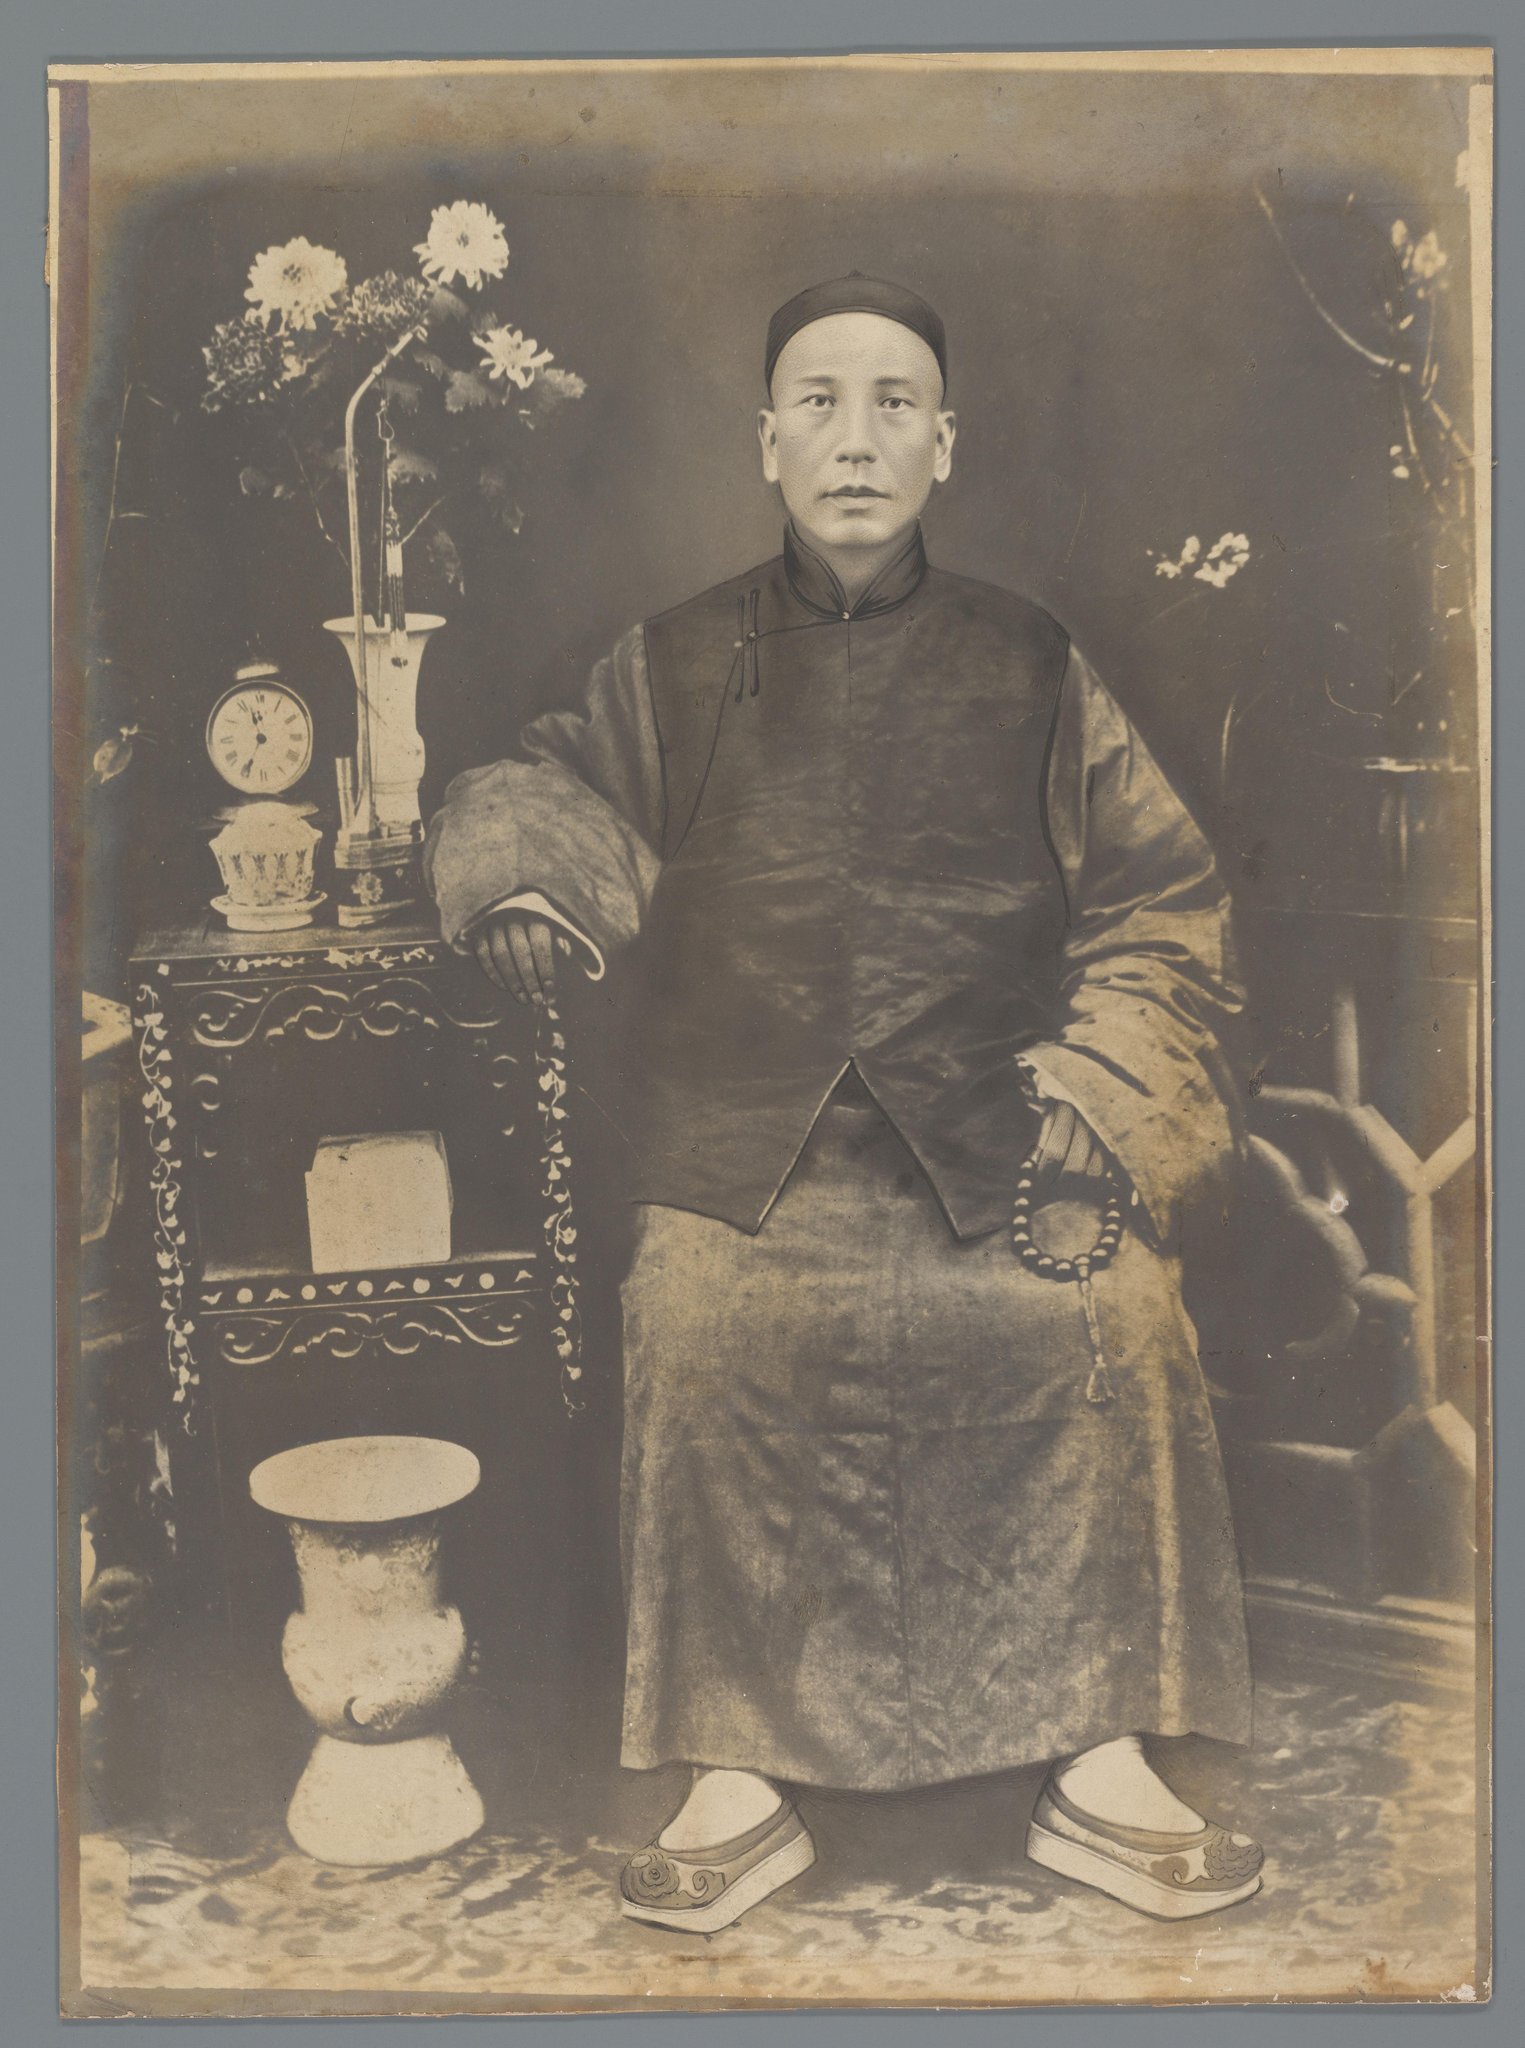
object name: crayon enlargement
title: Portret van een onbekende zittende Chinese man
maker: Anonymous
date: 1880-1910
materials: paper, cardboard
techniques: gelatin silver print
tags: sitting figure, anonymous historical person portrayed